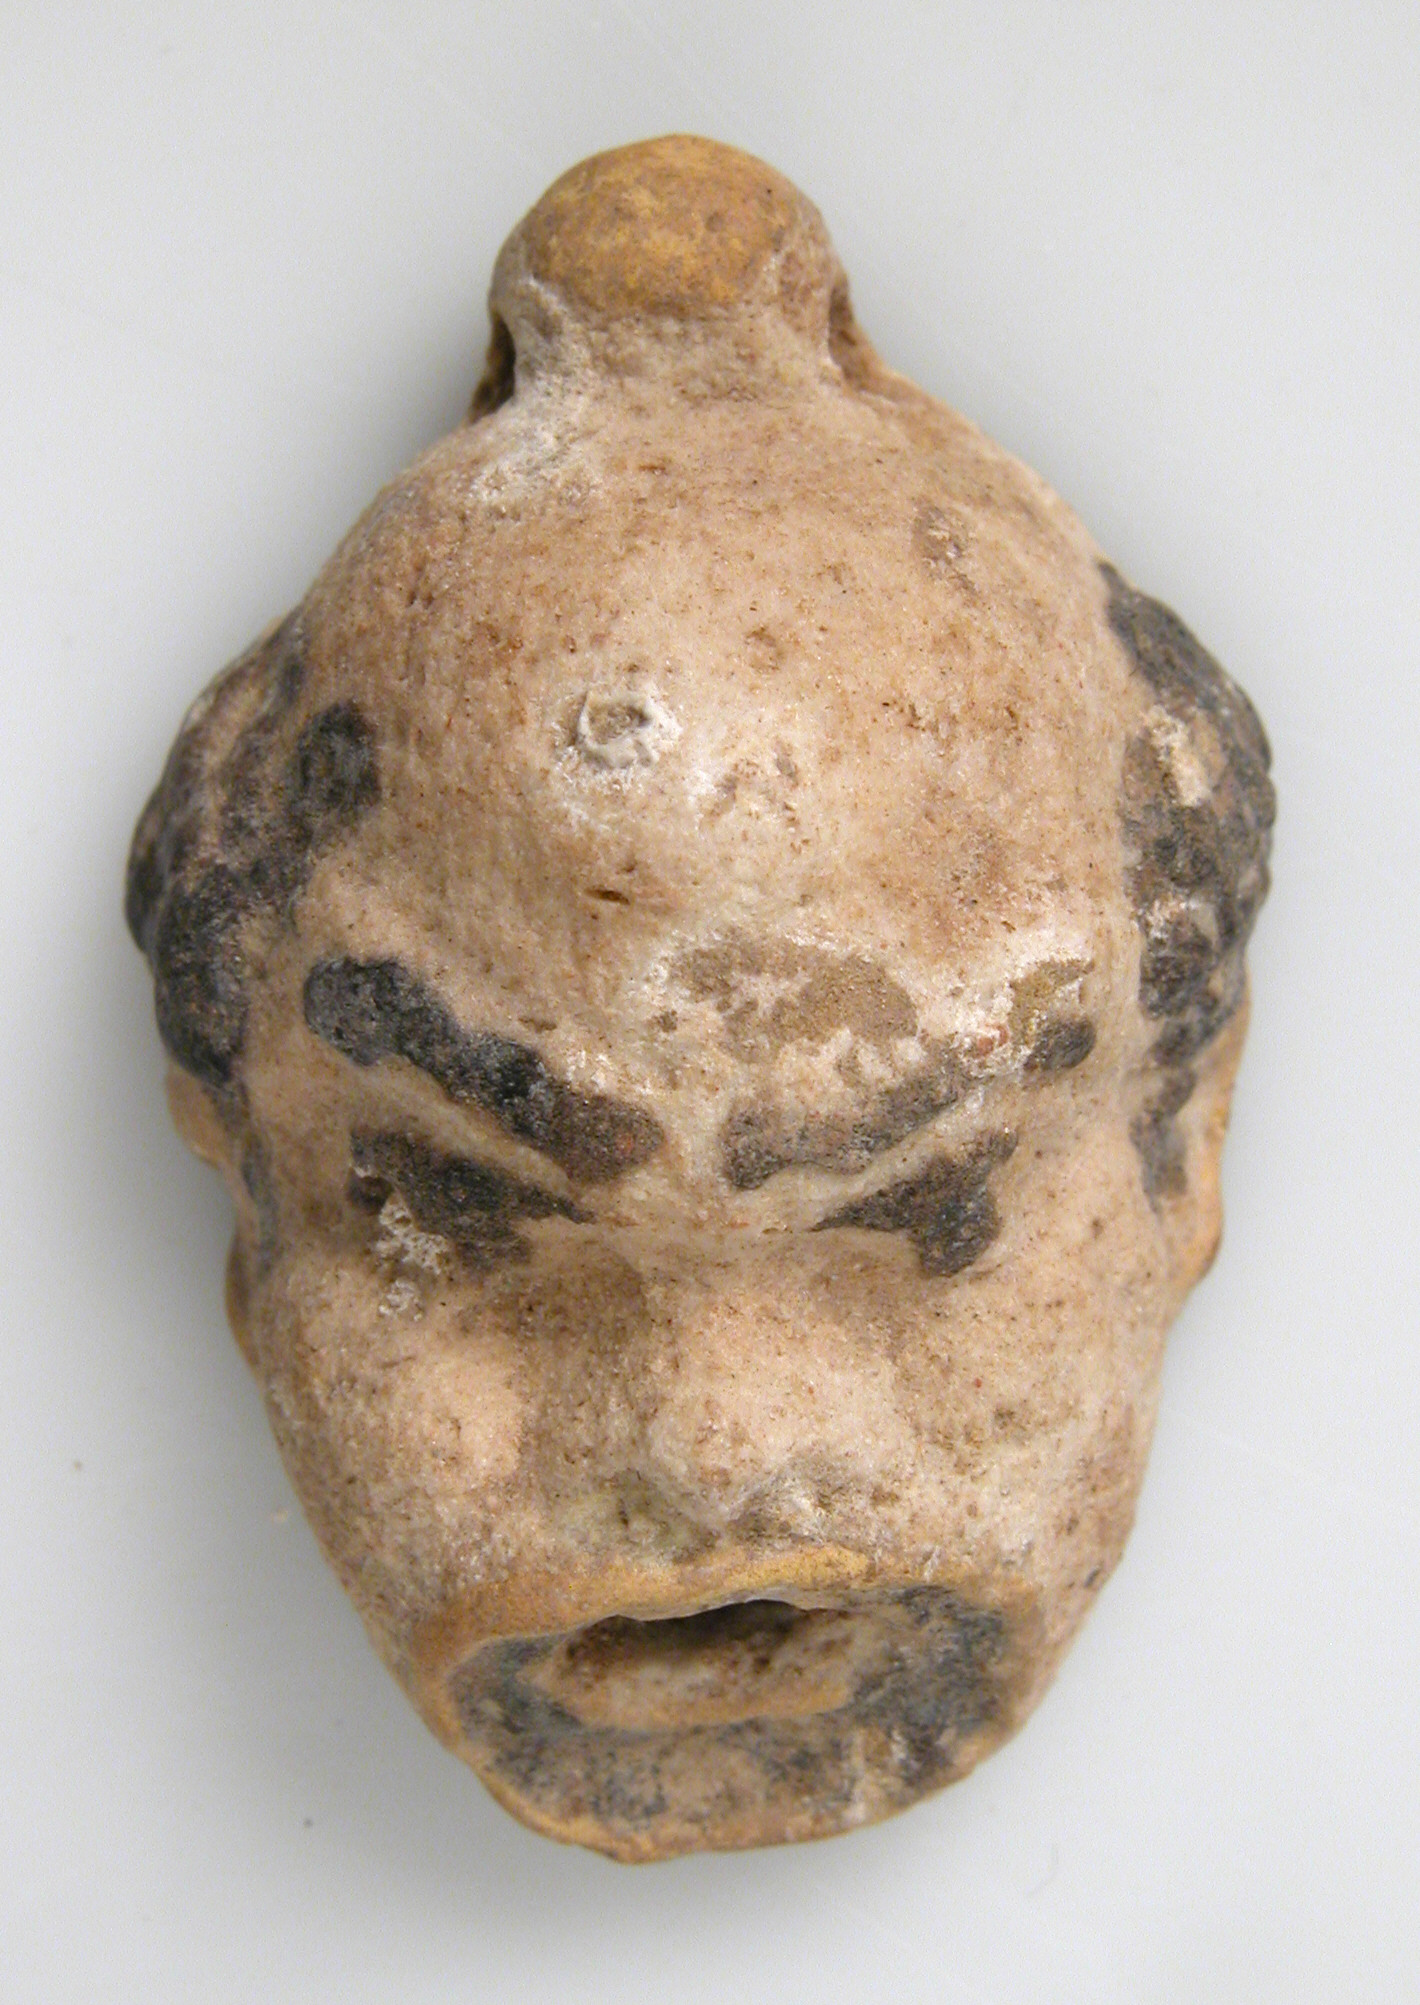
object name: pendant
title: Head Pendant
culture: coptic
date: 301-700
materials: plaster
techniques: painting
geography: egypt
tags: heads,men